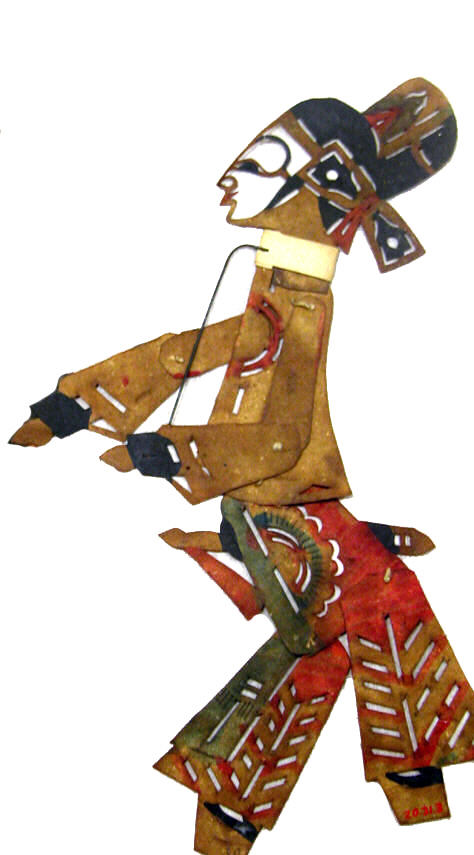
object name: shadow player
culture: chinese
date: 1801-1900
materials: cord, skin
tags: human figures